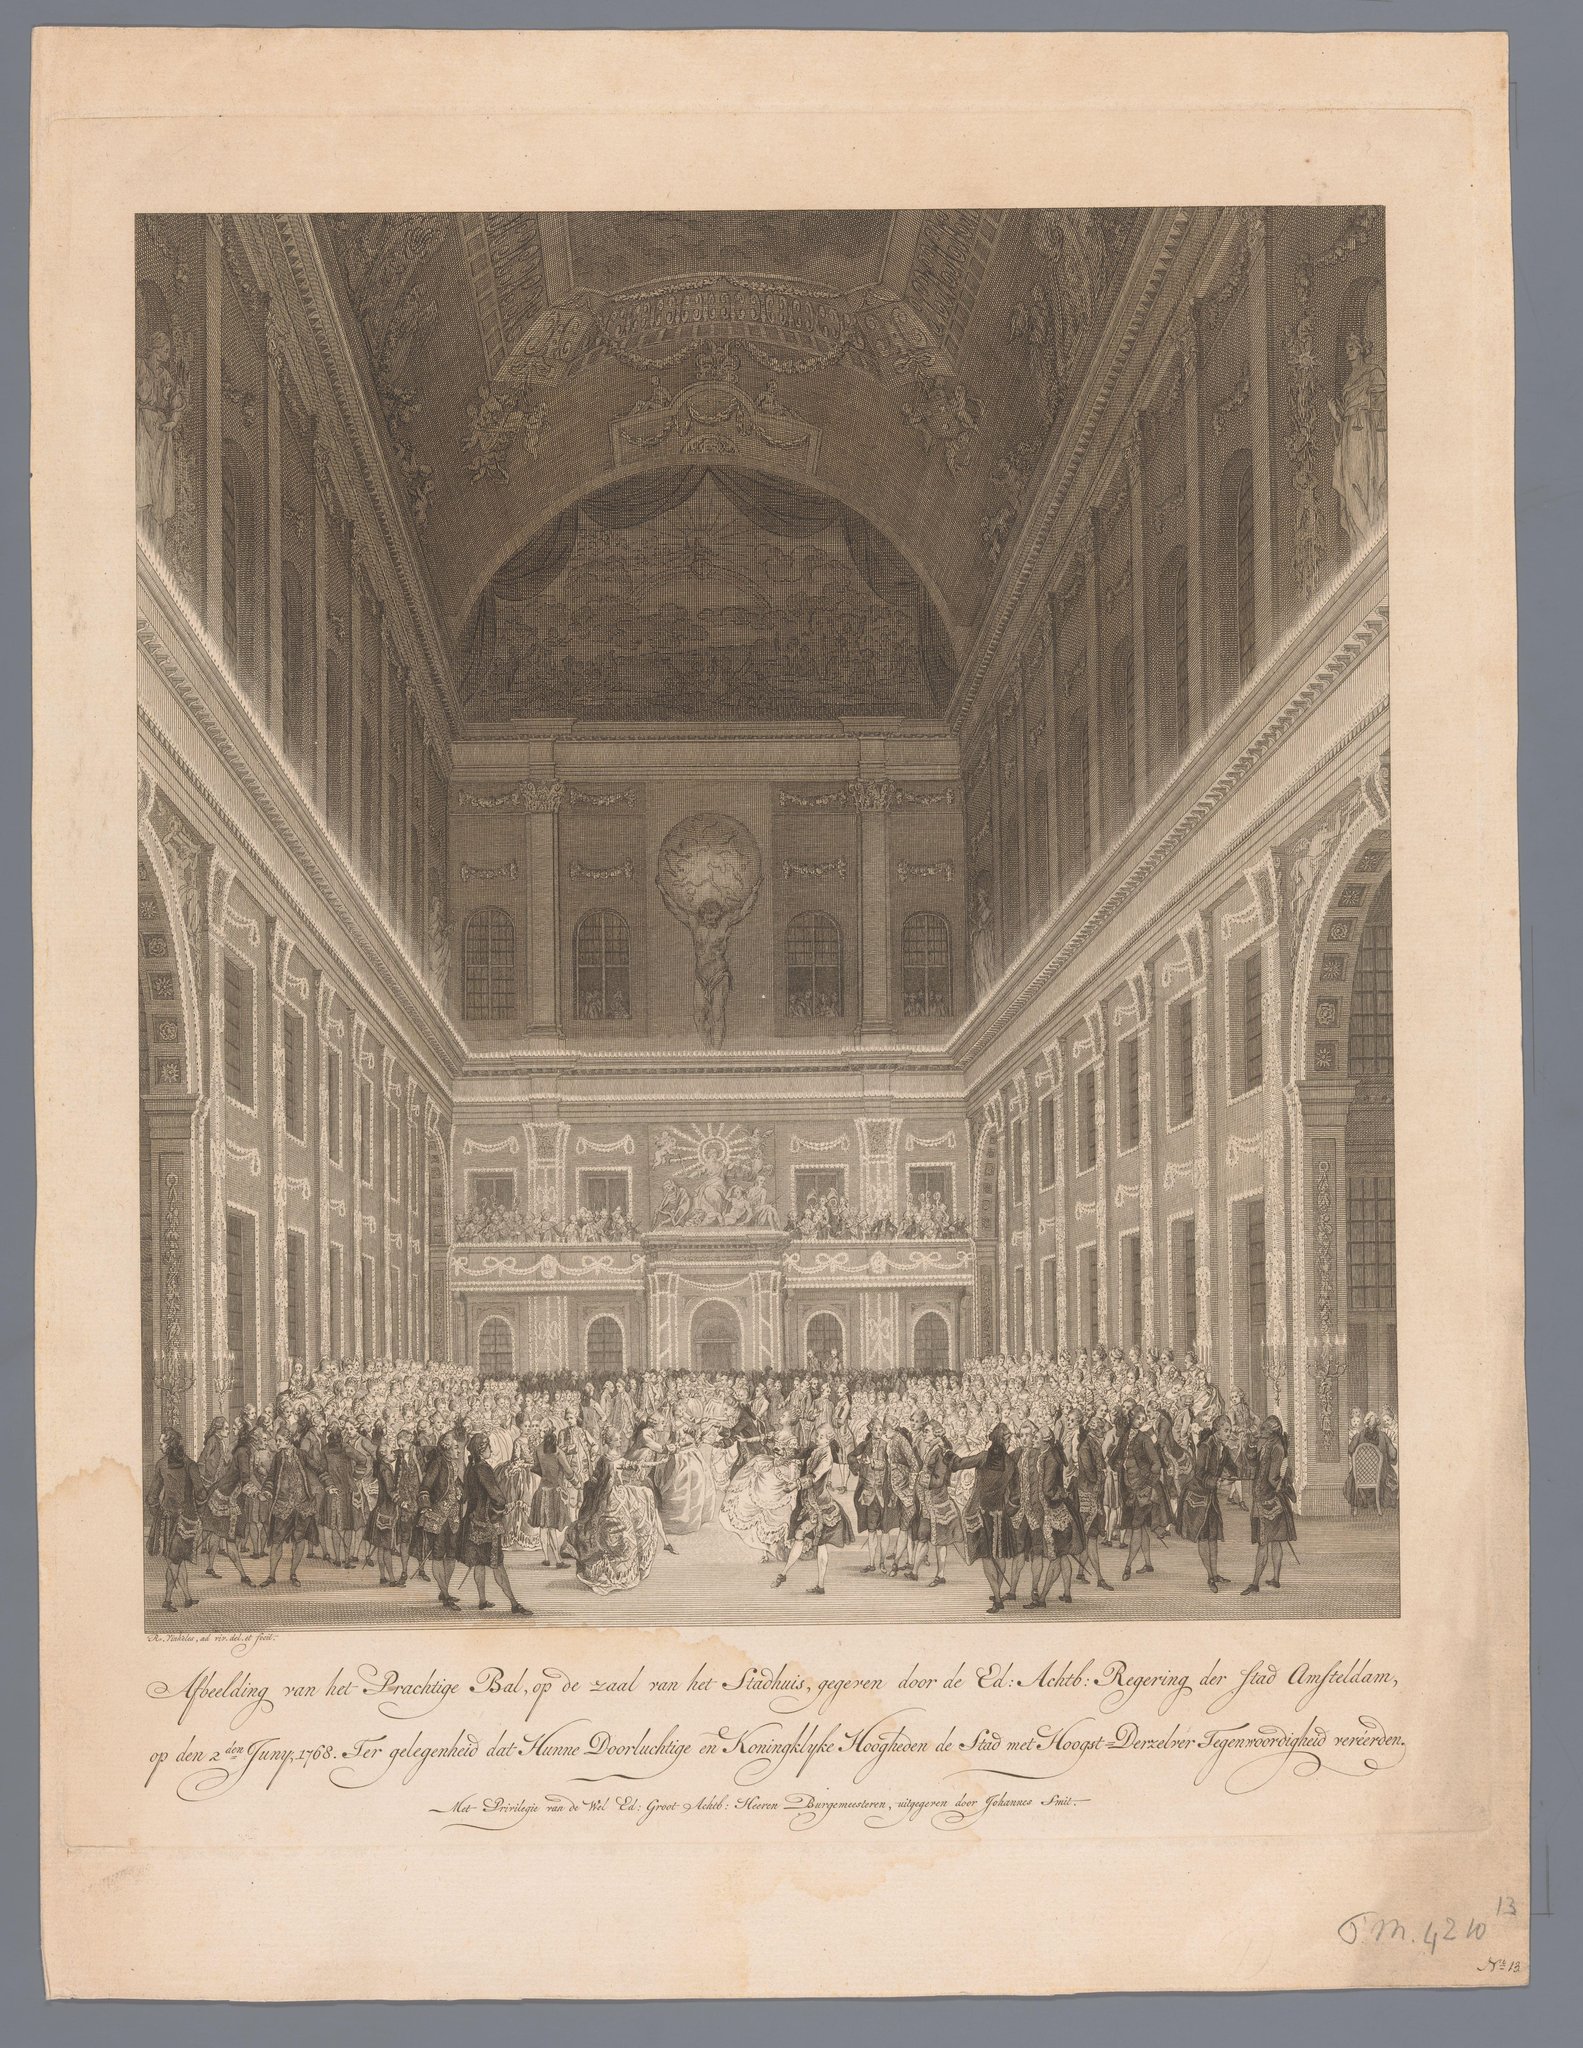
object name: print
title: Afbeelding van Prachtige Bal, op de zaal van het Stadhuis (...) op den 2den Juny 1768 (...)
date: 1773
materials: paper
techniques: engraving, etching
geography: amsterdam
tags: the hague, william v (prince of orange), berlin, draughtsman, wilhelmina of prussia (princess of orange), public festivities on the occasion of royal events (+ dancing ~ festive activities), ball, formal dance, townhall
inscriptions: inscription: ‘No. 13.’, collector's mark: Lugt 2233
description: Het bal in de Burgerzaal van het Amsterdamse stadhuis gegeven door het stadsbestuur ter gelegenheid van het bezoek van stadhouder Willem V en prinses Wilhelmina van Pruisen, 2 juni 1768. Onderdeel van een prentserie met titelprent en 14 platen van de inhaling van de prins en prinses te Amsterdam, 30 mei - 4 juni 1768. Rechtsonder handgeschreven genummerd: 13.